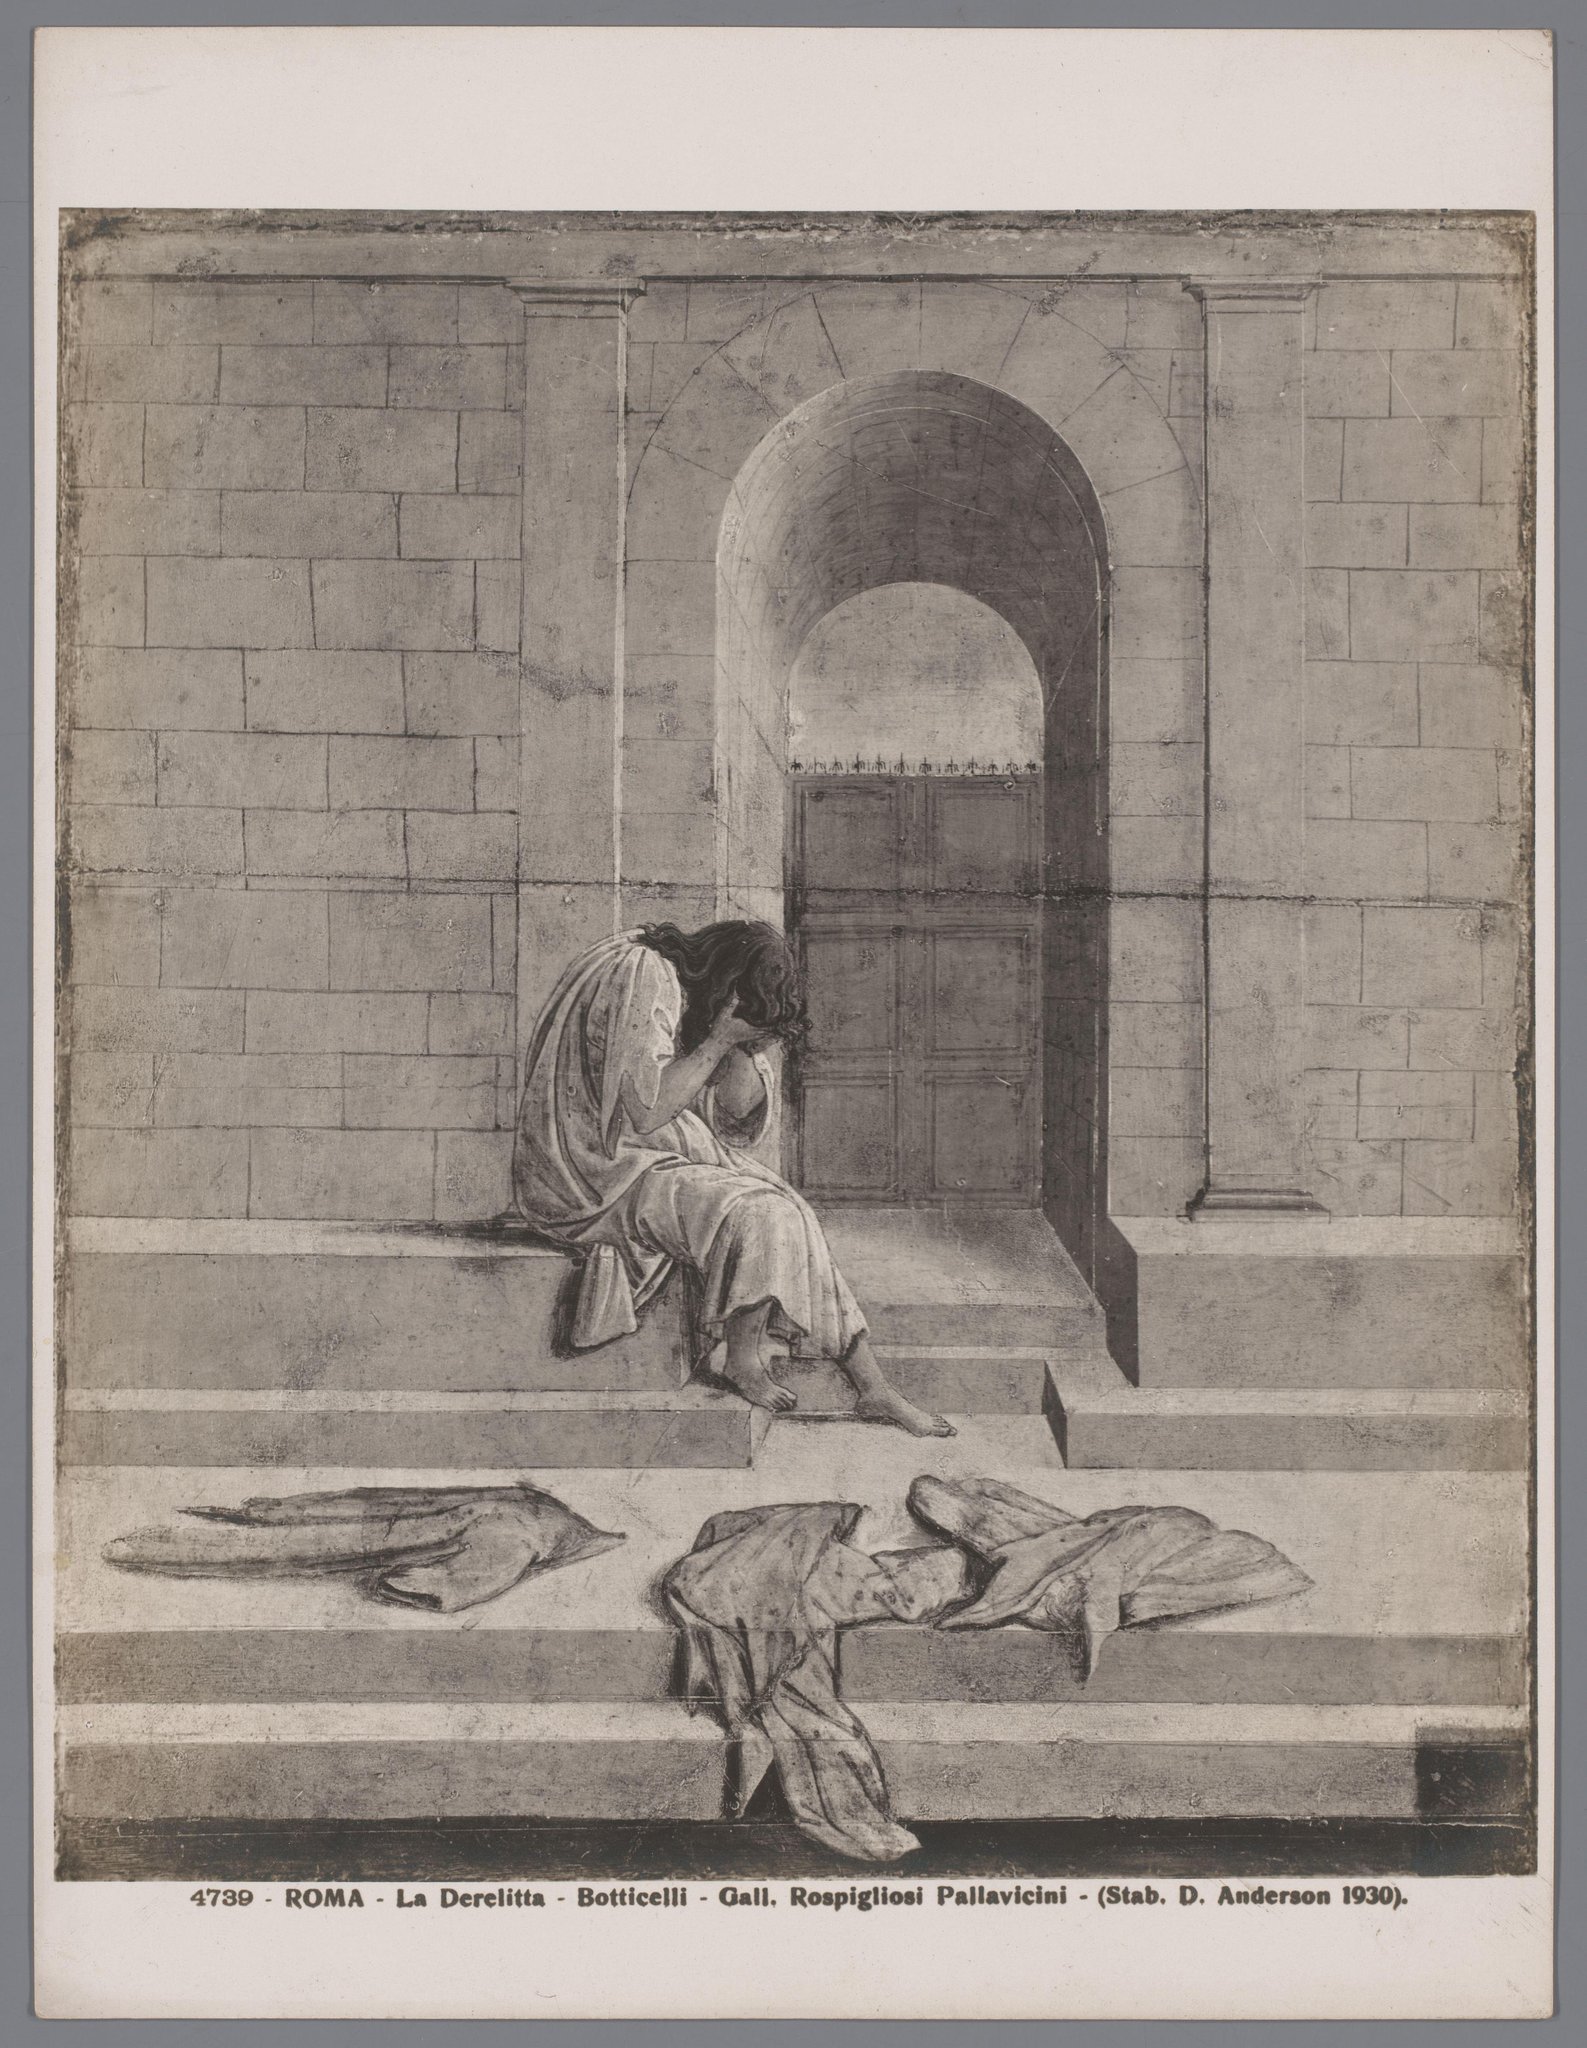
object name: photograph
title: Roma, la Derelitta, Botticelli, Gall. Rospigliosi Pallavicini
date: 1930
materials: paper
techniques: gelatin silver print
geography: rome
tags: the story of esther, weeping, rome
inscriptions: collector's mark: ‘VOSMAER’, number: ‘4739’, inscription: ‘1-5 Mrt 1930/ Burlington House/ London’